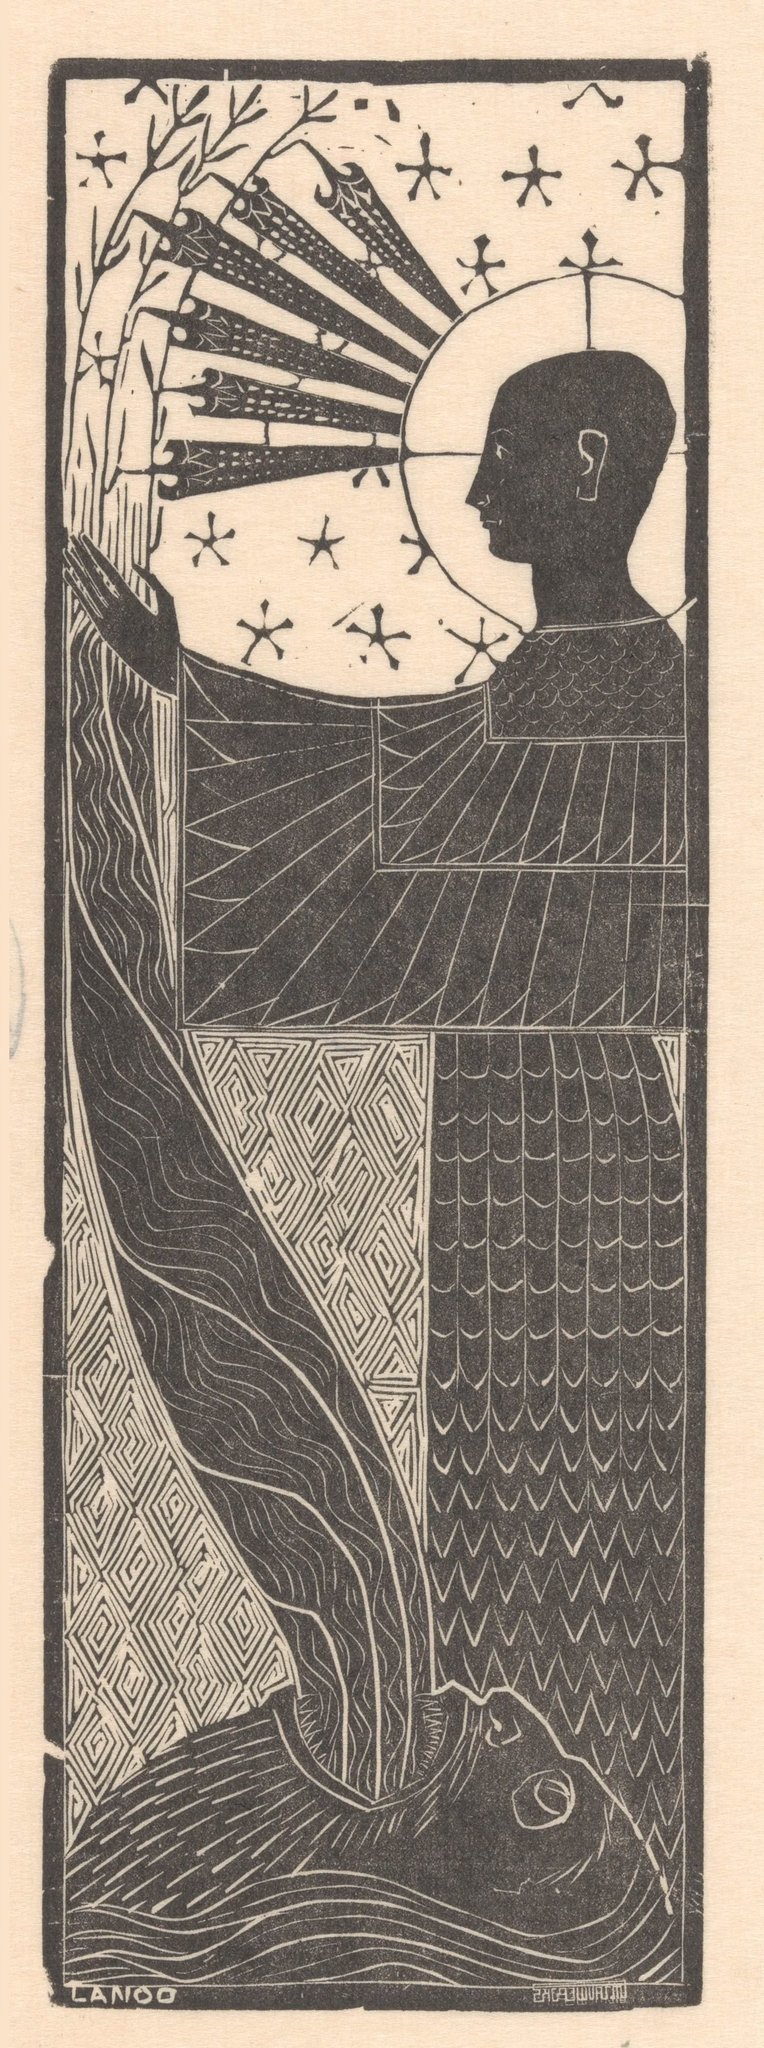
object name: illustration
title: Twaalf houtsneden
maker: mathieu lauweriks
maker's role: designer, draughtsman, print maker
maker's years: 1864-1932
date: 1894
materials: paper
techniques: woodcut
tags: mouth wide open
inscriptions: collector's mark: Lugt 2228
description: Prent mogelijk gebruikt voor: Licht en waarheid. Orgaan van de vereeniging 'Wie Denkt Overwint'. Amsterdam: Wie Denkt Overwint, 15 september 1894. Het betreft een postume afdruk.